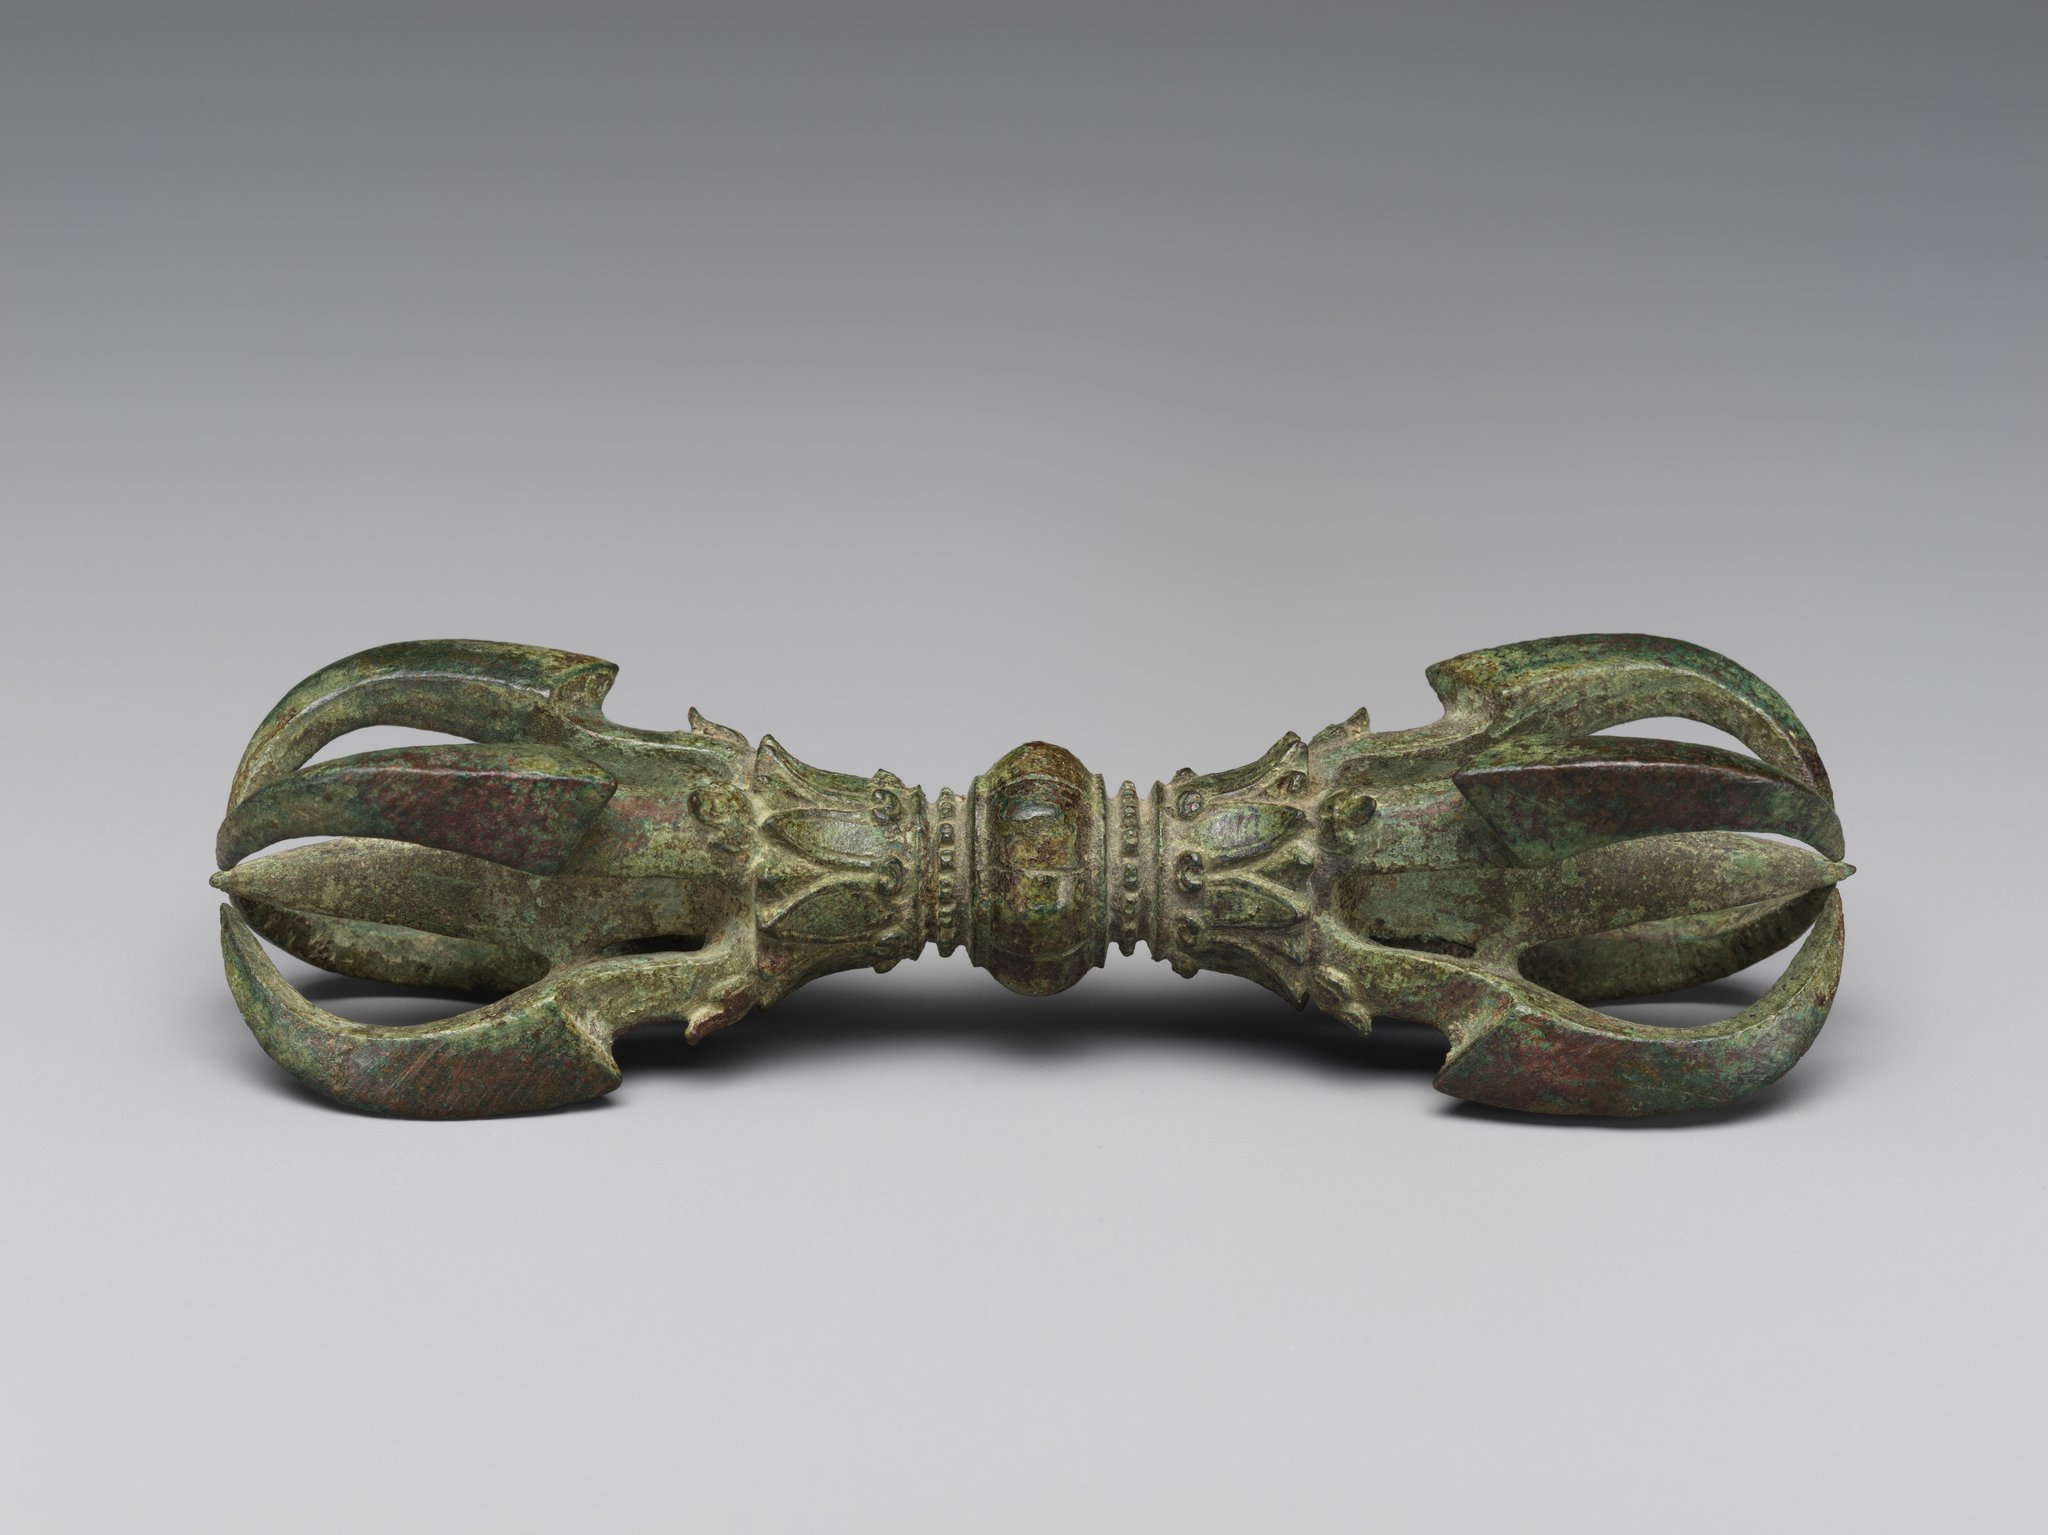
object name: vajra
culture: indonesian, javanese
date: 901-1000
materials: bronze